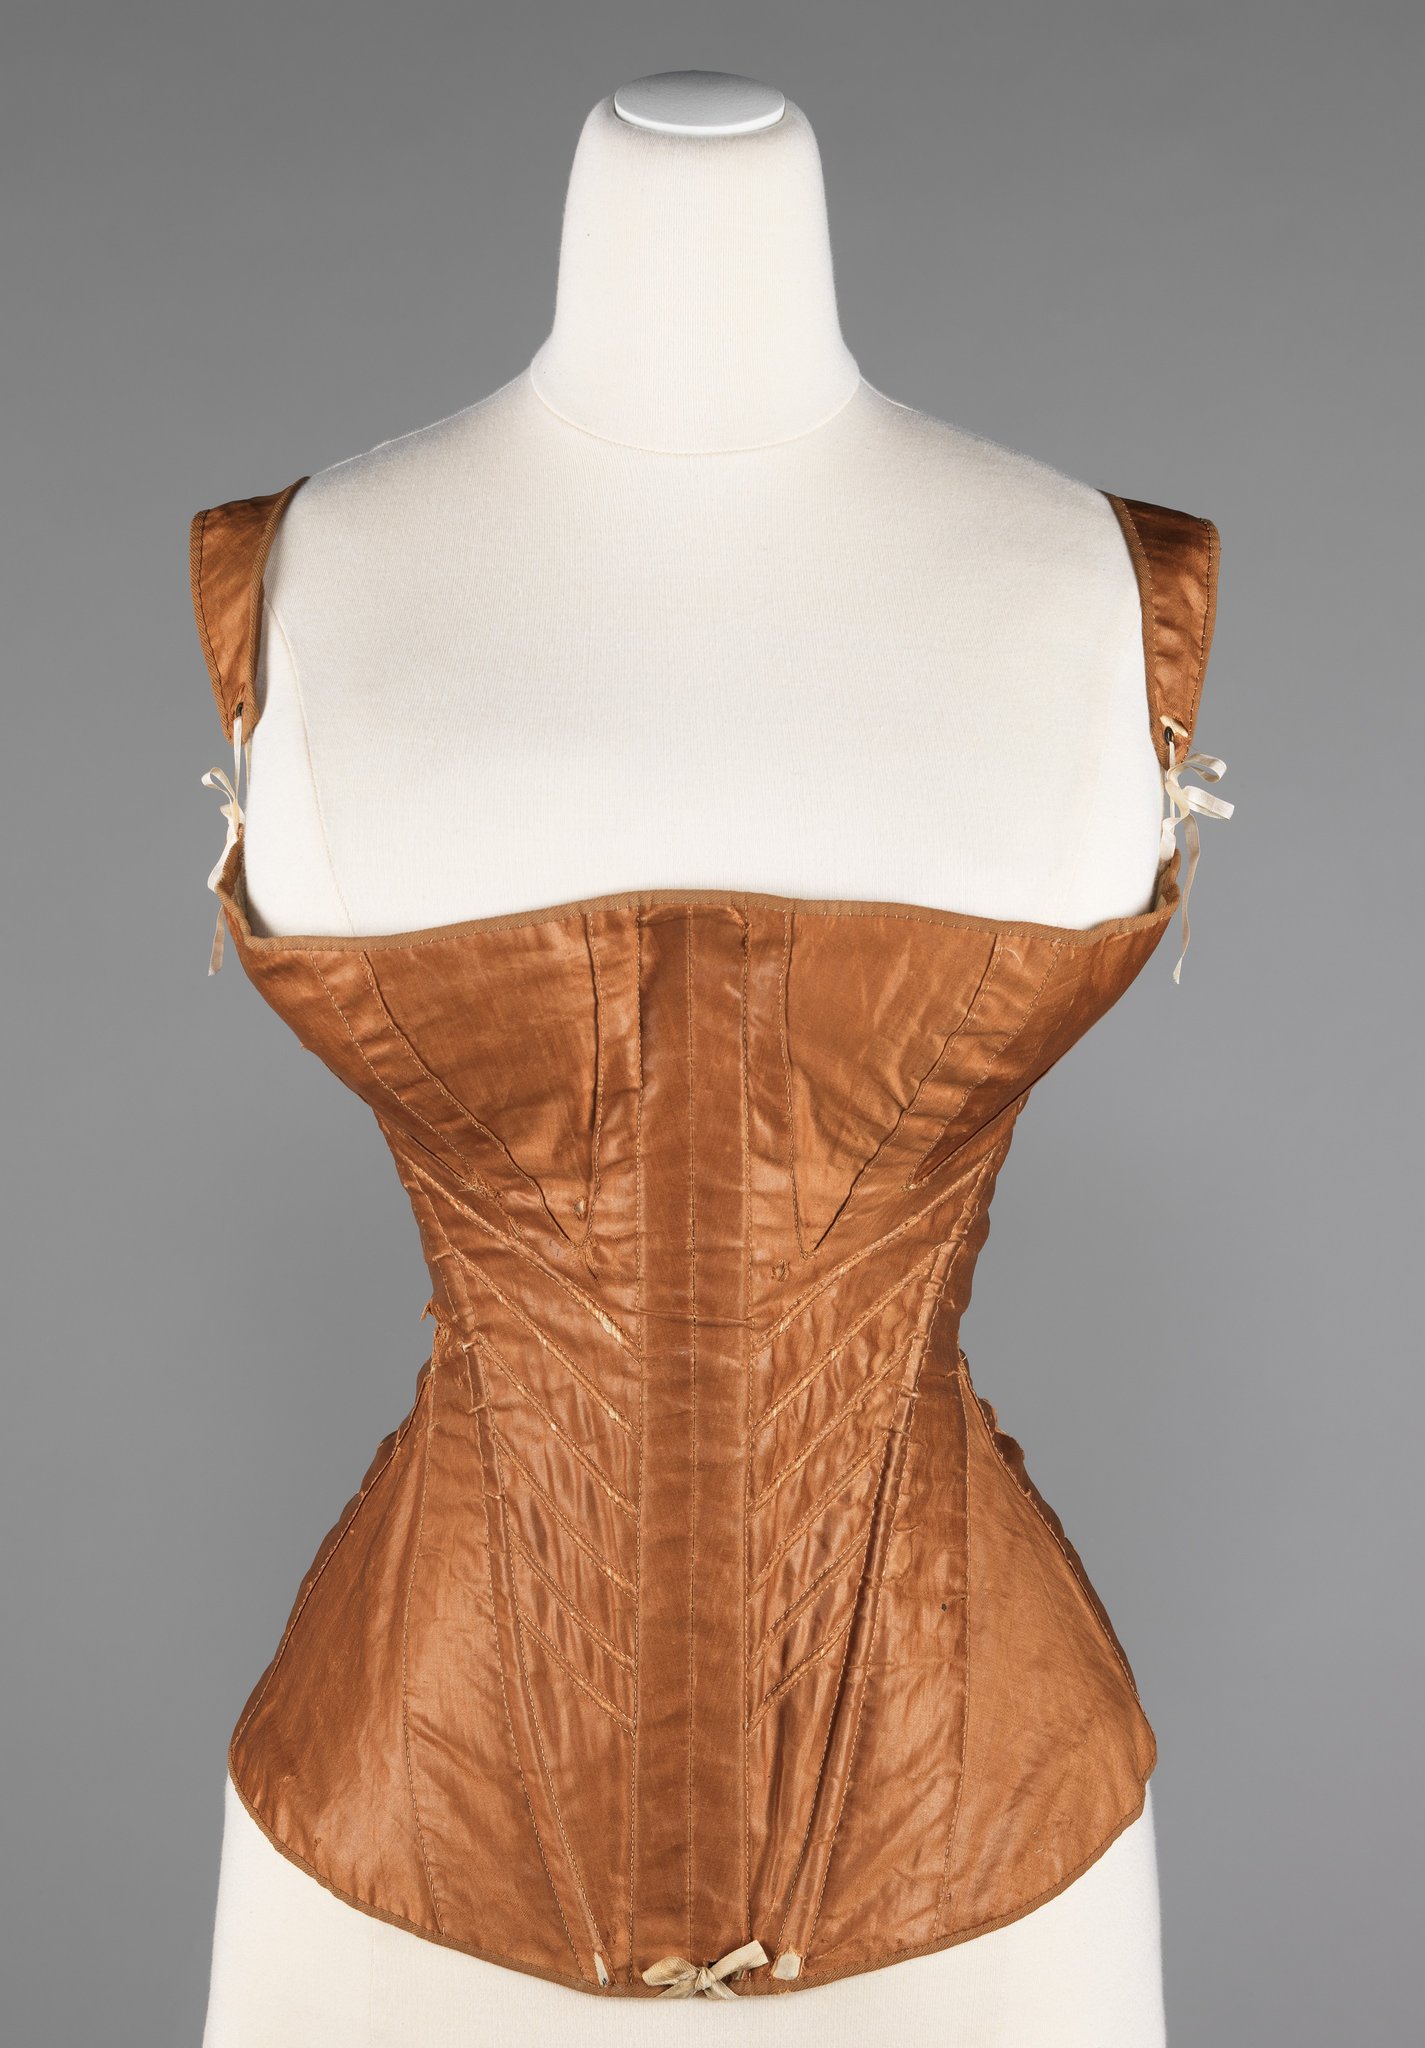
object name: corset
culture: american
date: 1830-1835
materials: bone, cotton, metal